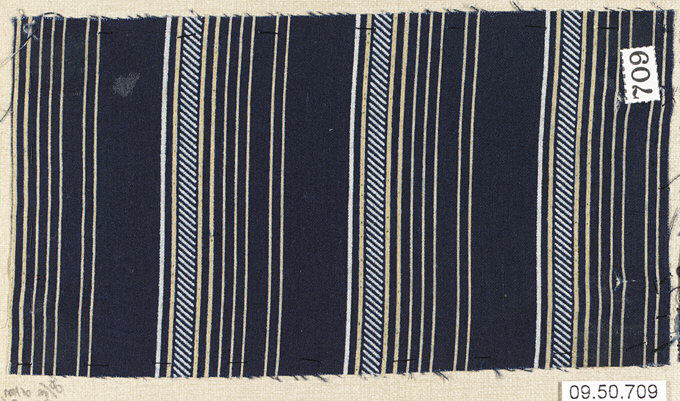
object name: piece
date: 1801-1900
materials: cotton